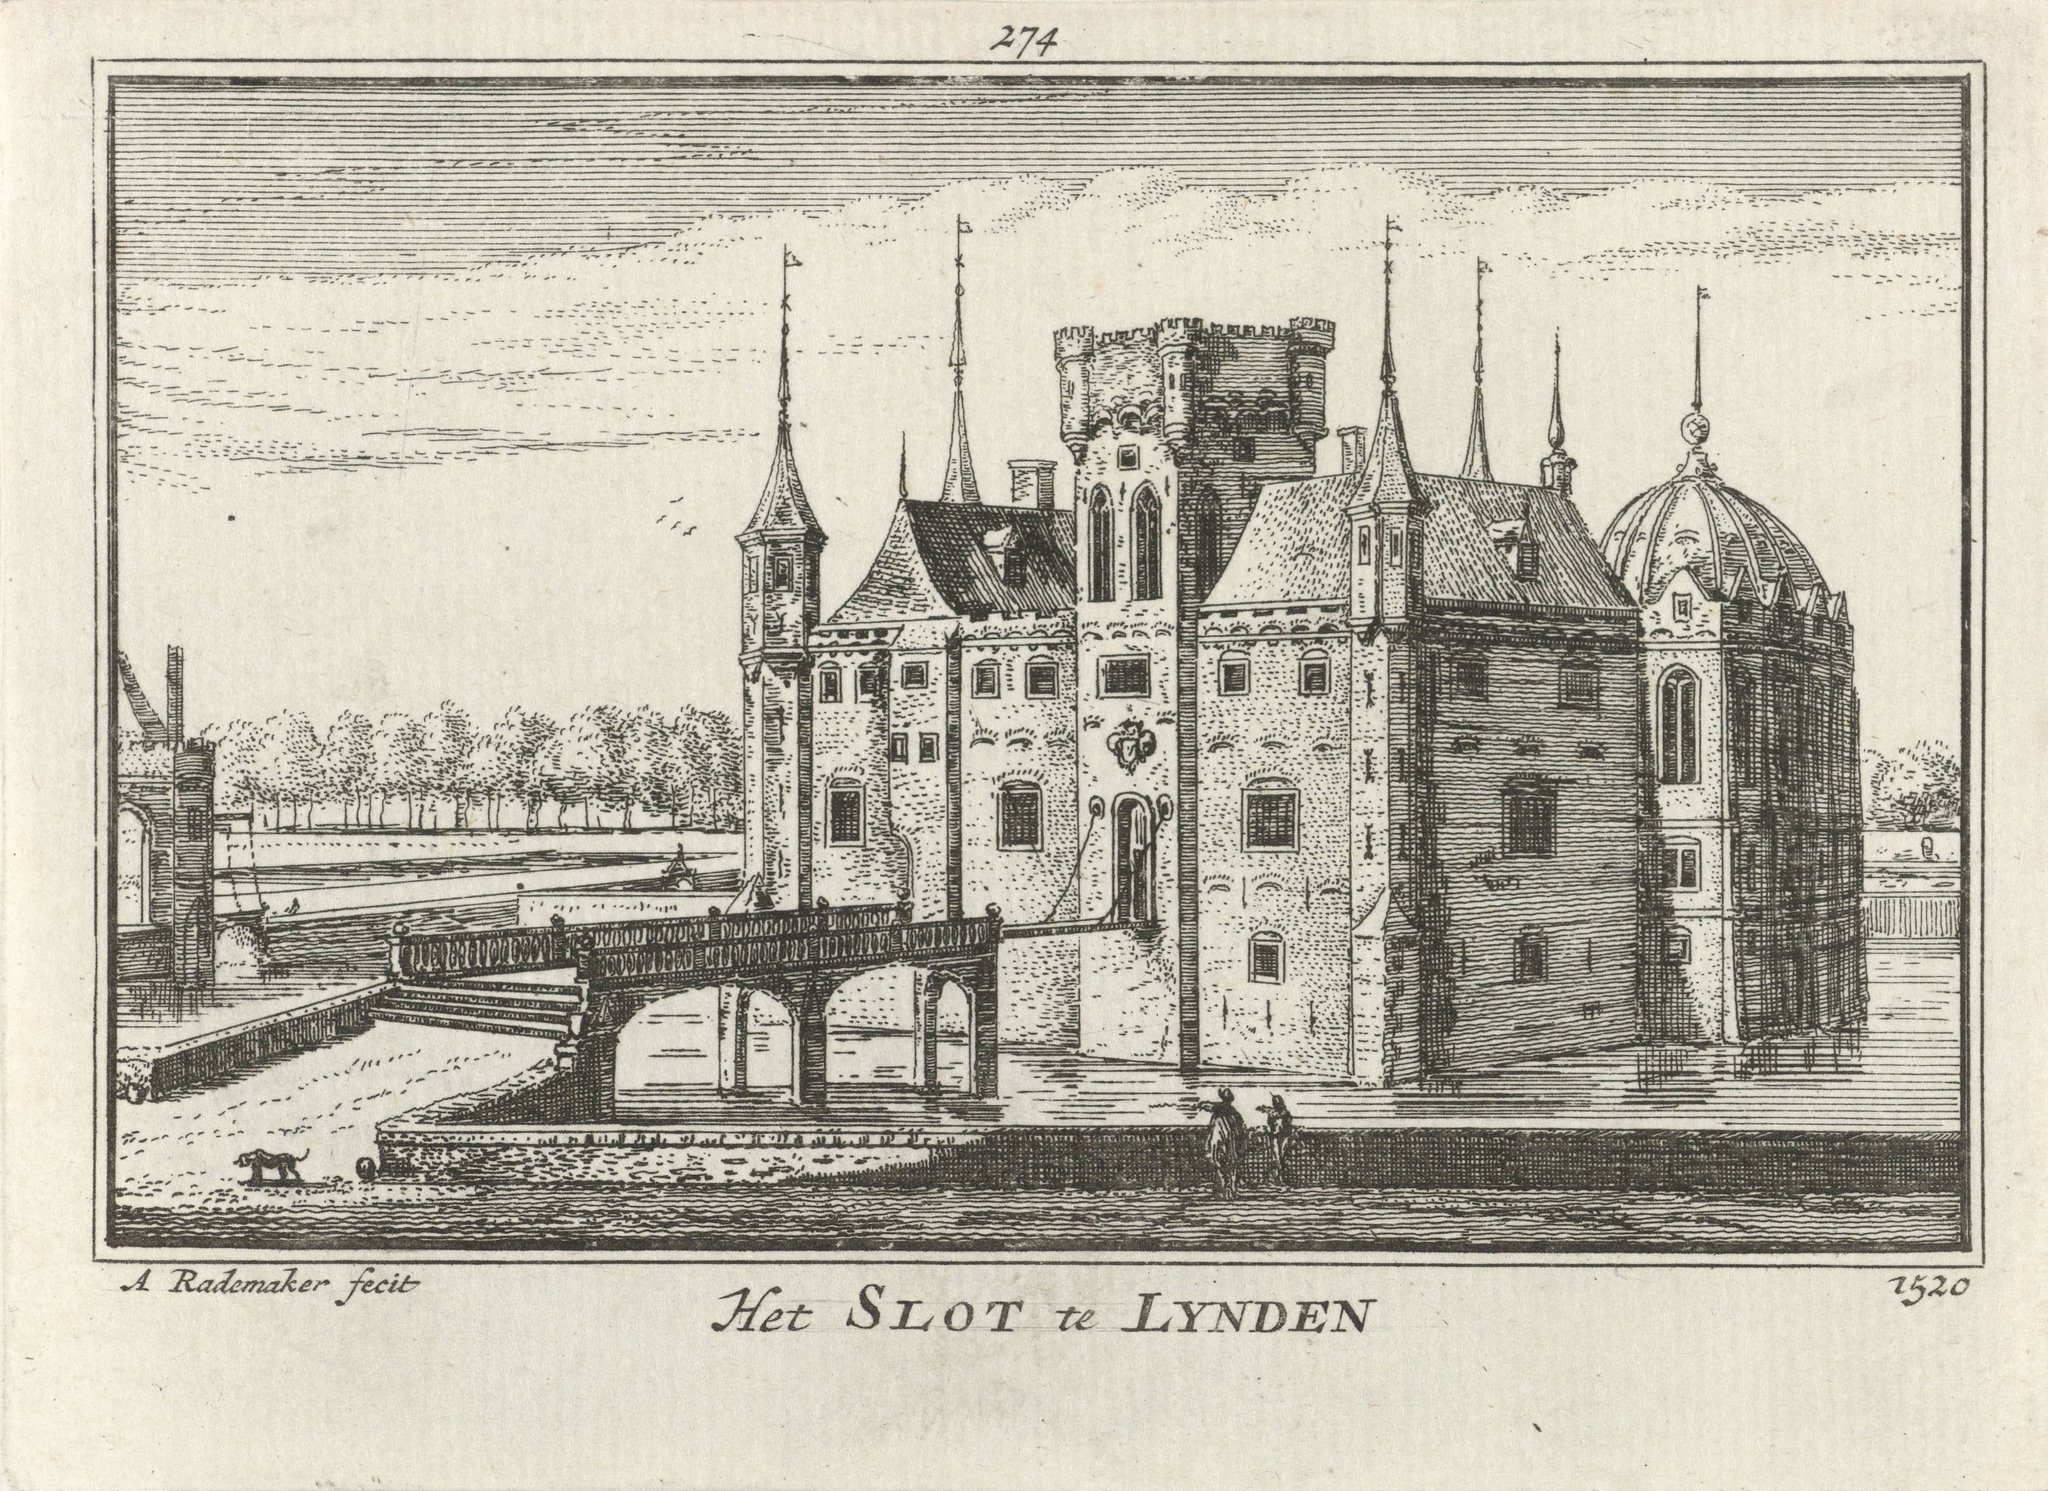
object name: print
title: Huis ter Lede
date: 1727-1733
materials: paper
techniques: etching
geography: amsterdam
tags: castle, dog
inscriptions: collector's mark: Lugt 2228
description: Illustratie uit: Abraham Rademaker, Matthaeus Brouërius van Niedek, Isaac Le Long, Kabinet van Nederlandsche en Kleefsche outheden en (...) voorname stads- en landgebouwen, Willem Barents en Antoni Schoonenburg: Amsterdam, 1727-1733, ill. nr. 274.